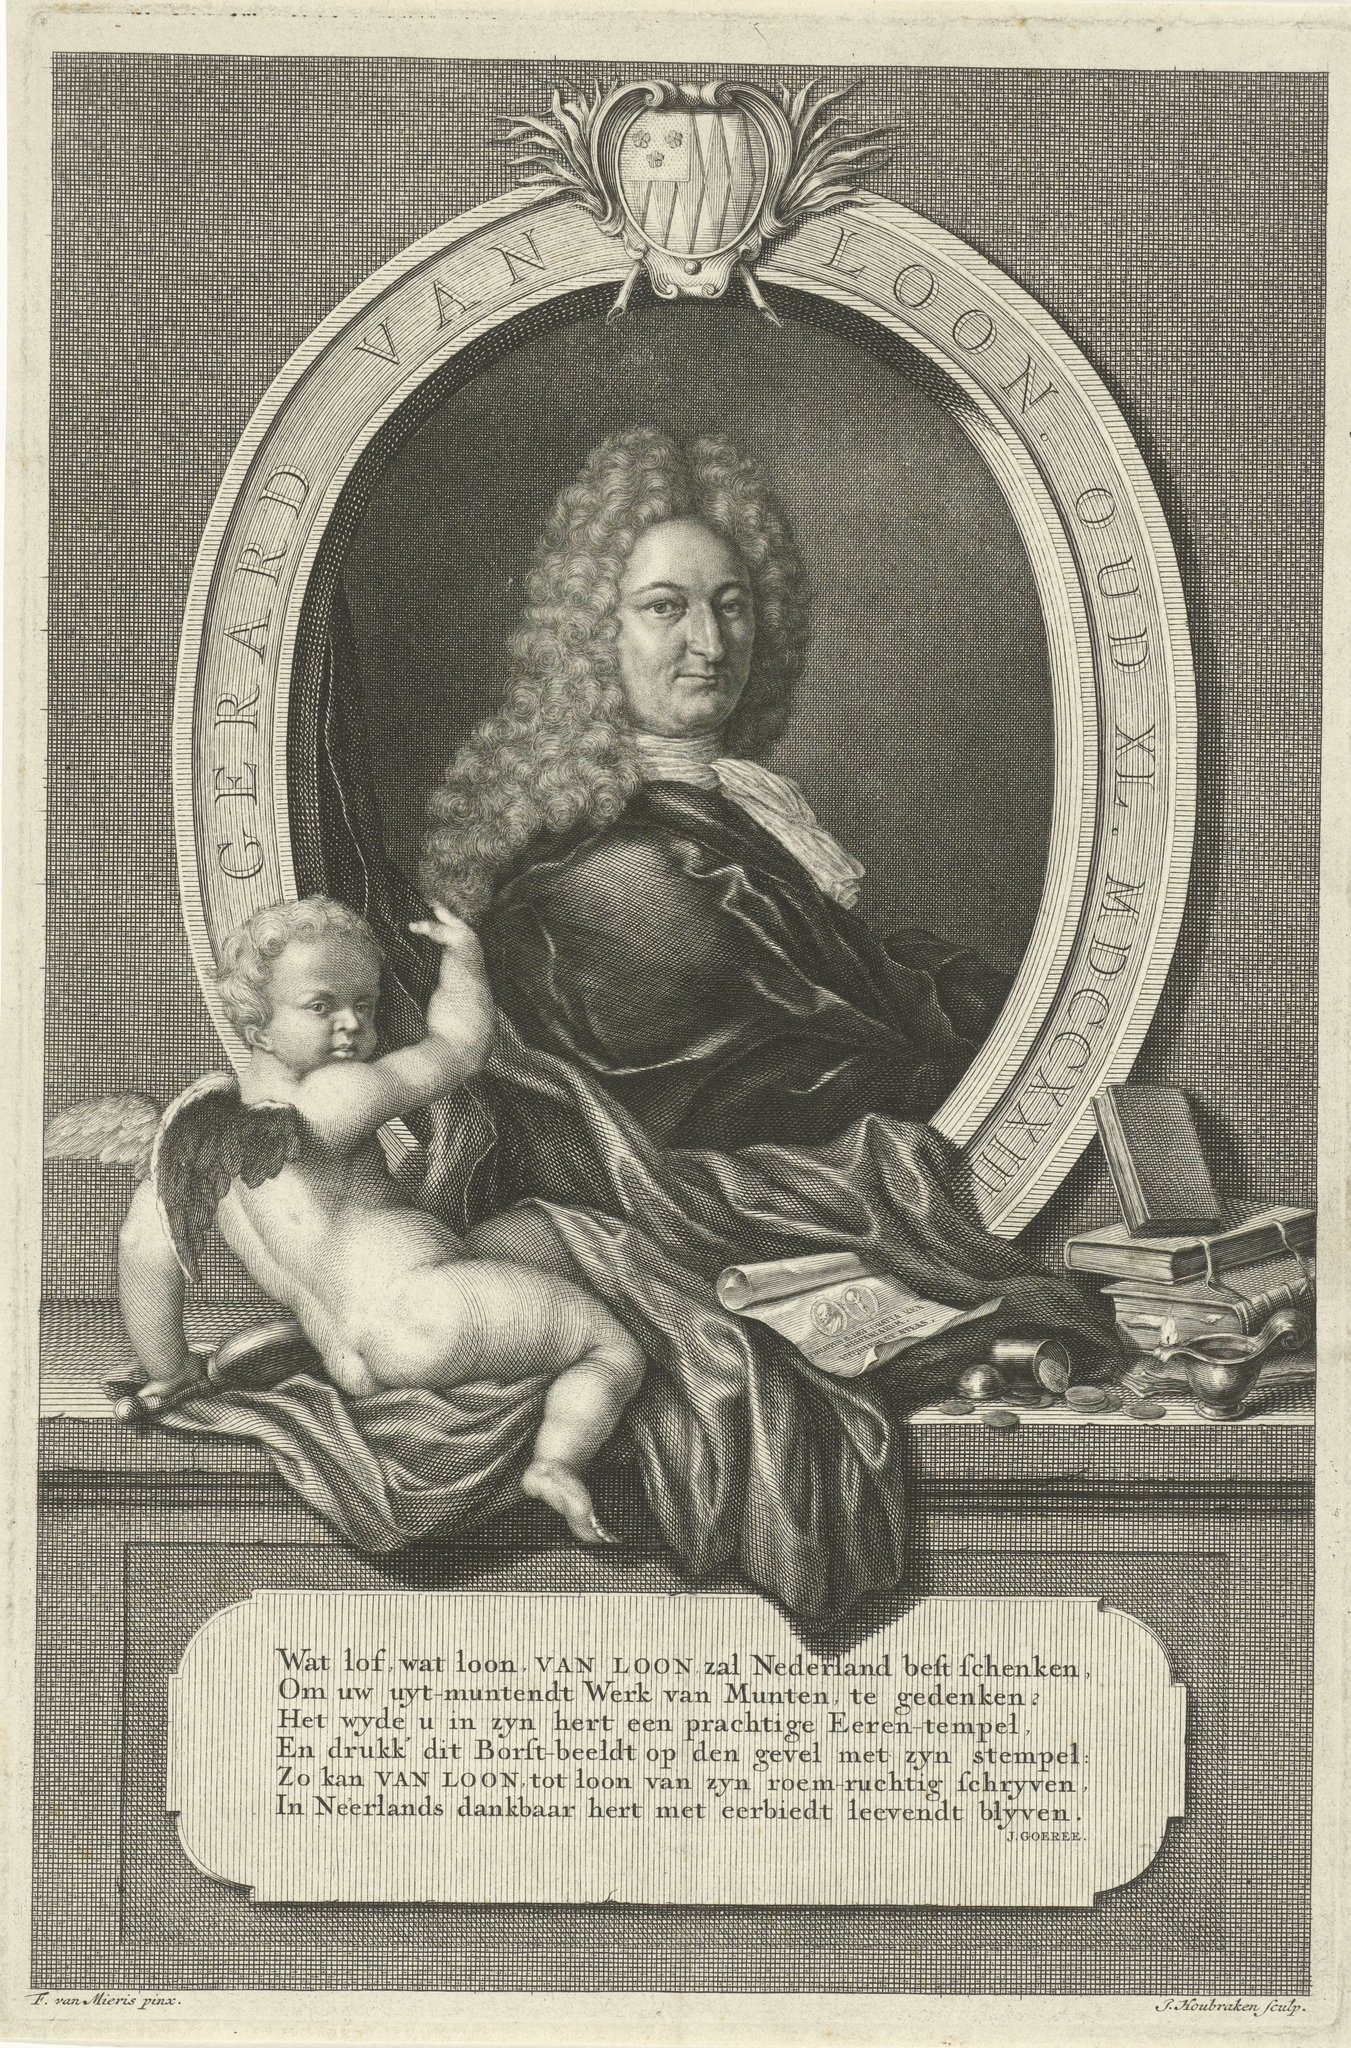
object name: print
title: Portret van Gerard van Loon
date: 1723-1732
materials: paper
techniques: engraving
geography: amsterdam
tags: designer, gerard van loon, cupids: 'amores', 'amoretti', 'putti'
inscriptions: collector's mark: Lugt 240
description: Buste naar rechts van Gerard van Loon op 40-jarige leeftijd in een ovaal met randschrift en met bovenaan een wapen. Het portret rust op een sokkel met daarop een cartouche met een zesregelig vers in het Nederlands. Links op de sokkel naast het portret een putto die een stuk gordijn openhoudt en rechts boeken, een olielampje en munten.